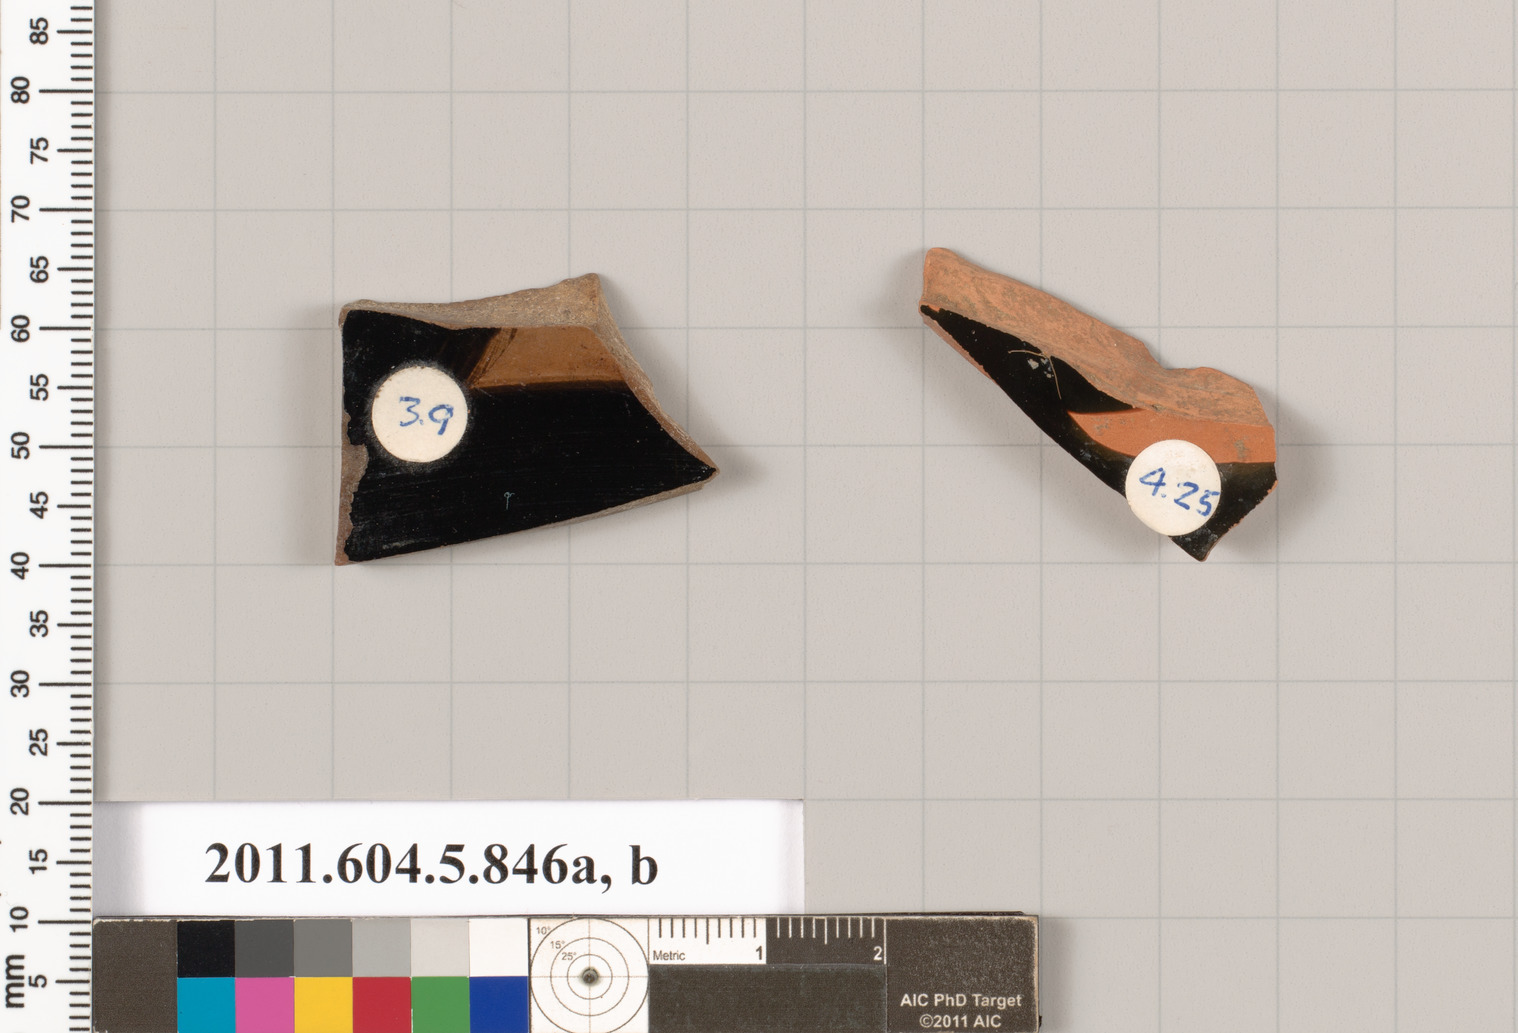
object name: kylix fragment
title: Terracotta fragments of kylikes (drinking cups)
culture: greek, attic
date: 600-401 BCE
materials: terracotta